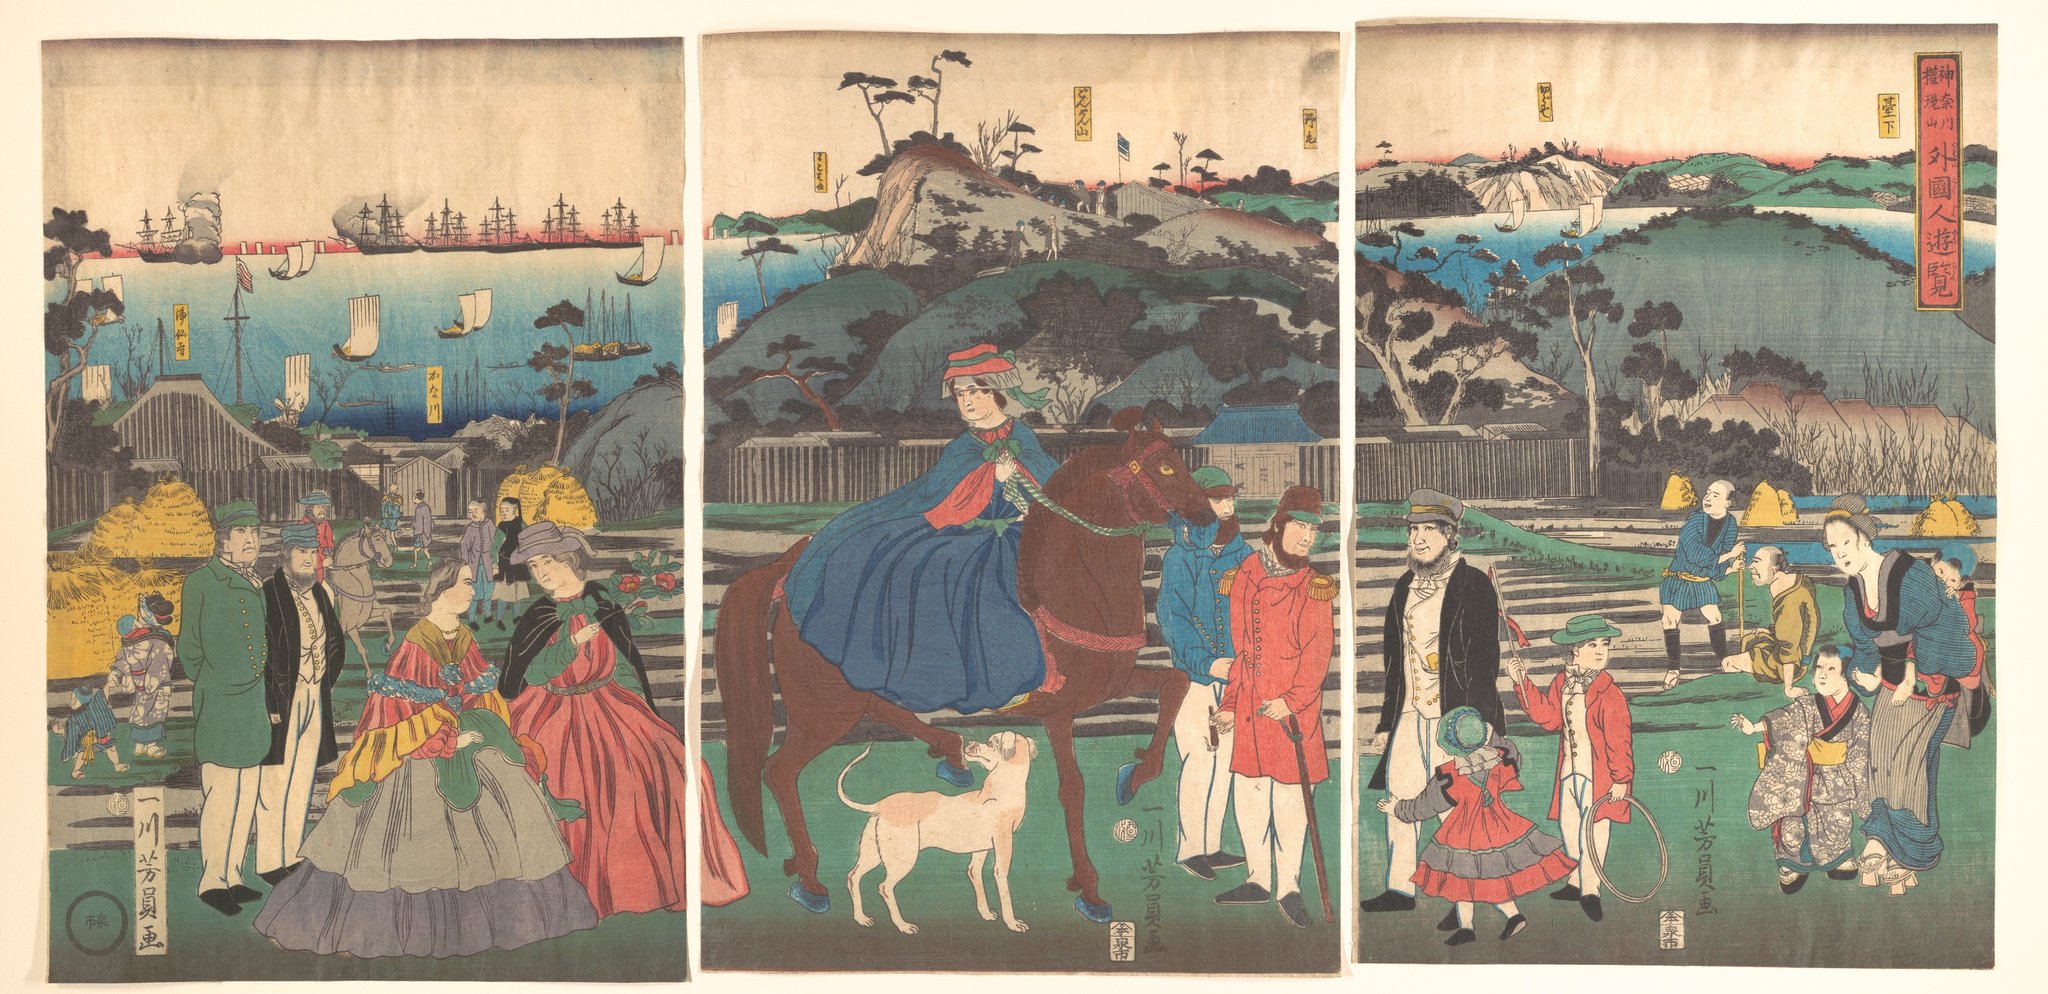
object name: print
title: Foreigners Visiting the Famous Site of Mt. Gongen in Kanagawa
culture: japanese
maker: utagawa yoshikazu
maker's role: artist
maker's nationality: japanese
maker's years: 1845-1870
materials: ink, paper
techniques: woodblock print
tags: men,women,dogs,horses,ships